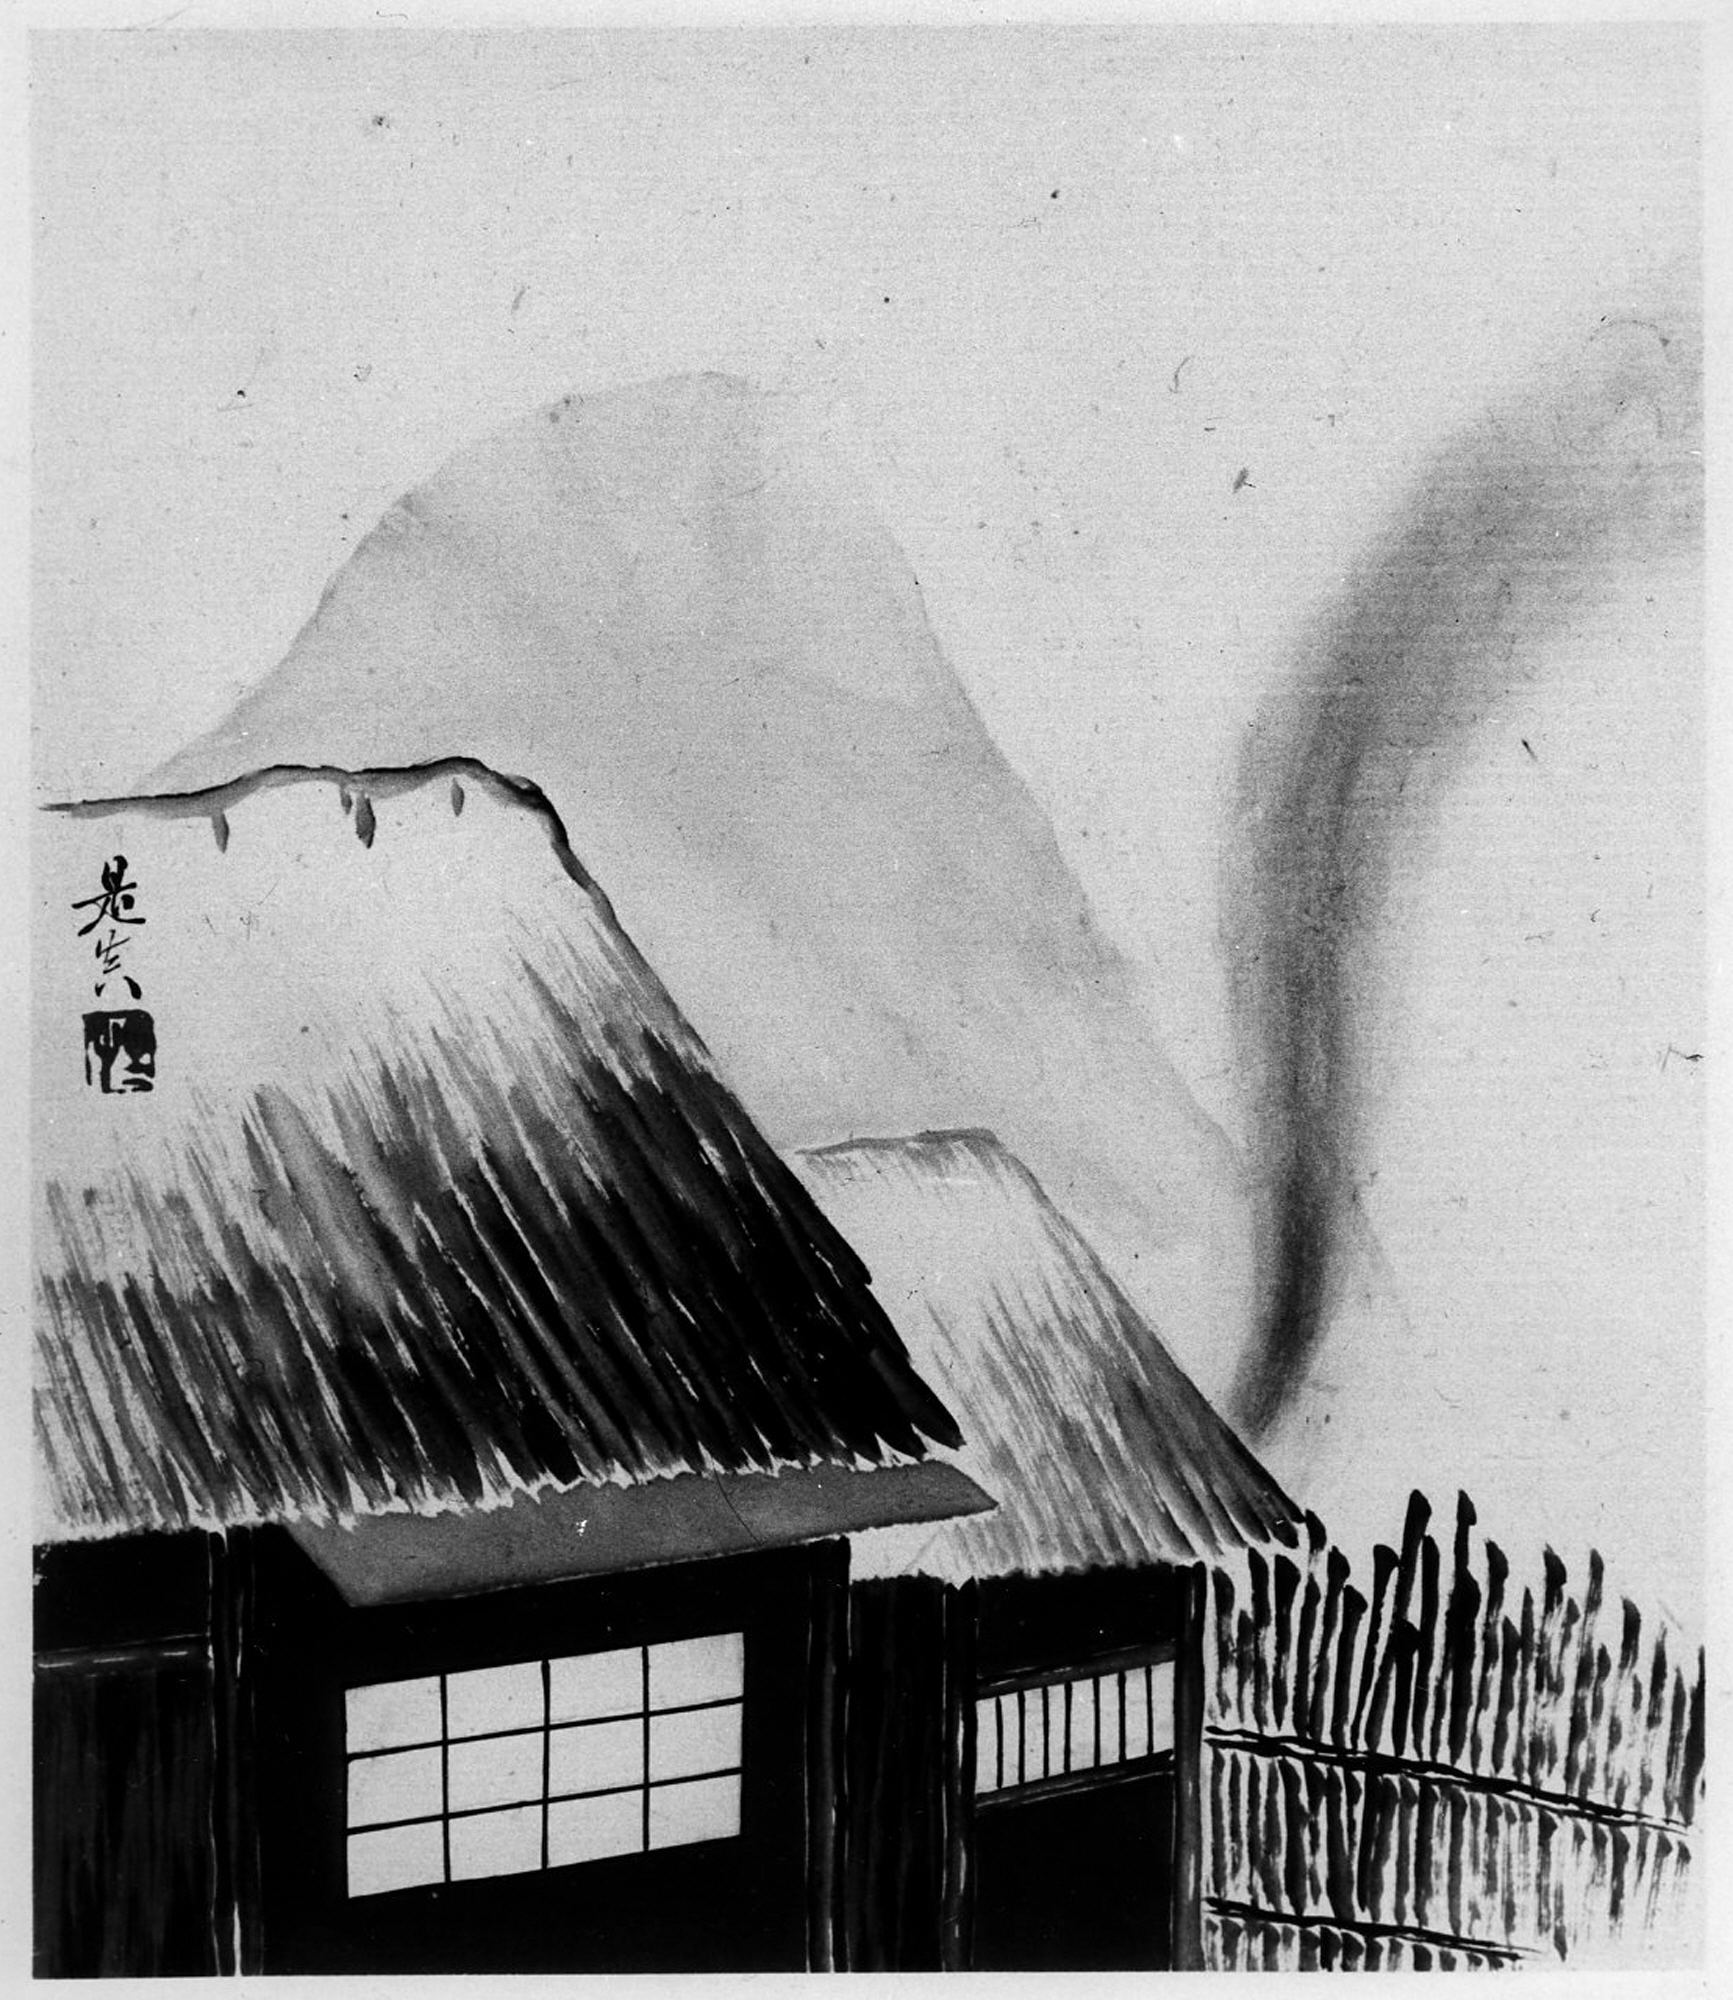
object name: painting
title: Cottage and Mountains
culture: japanese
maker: shibata zeshin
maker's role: artist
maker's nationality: japanese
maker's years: 1807-1891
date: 1801-1900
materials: paper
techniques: painting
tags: houses,mountains